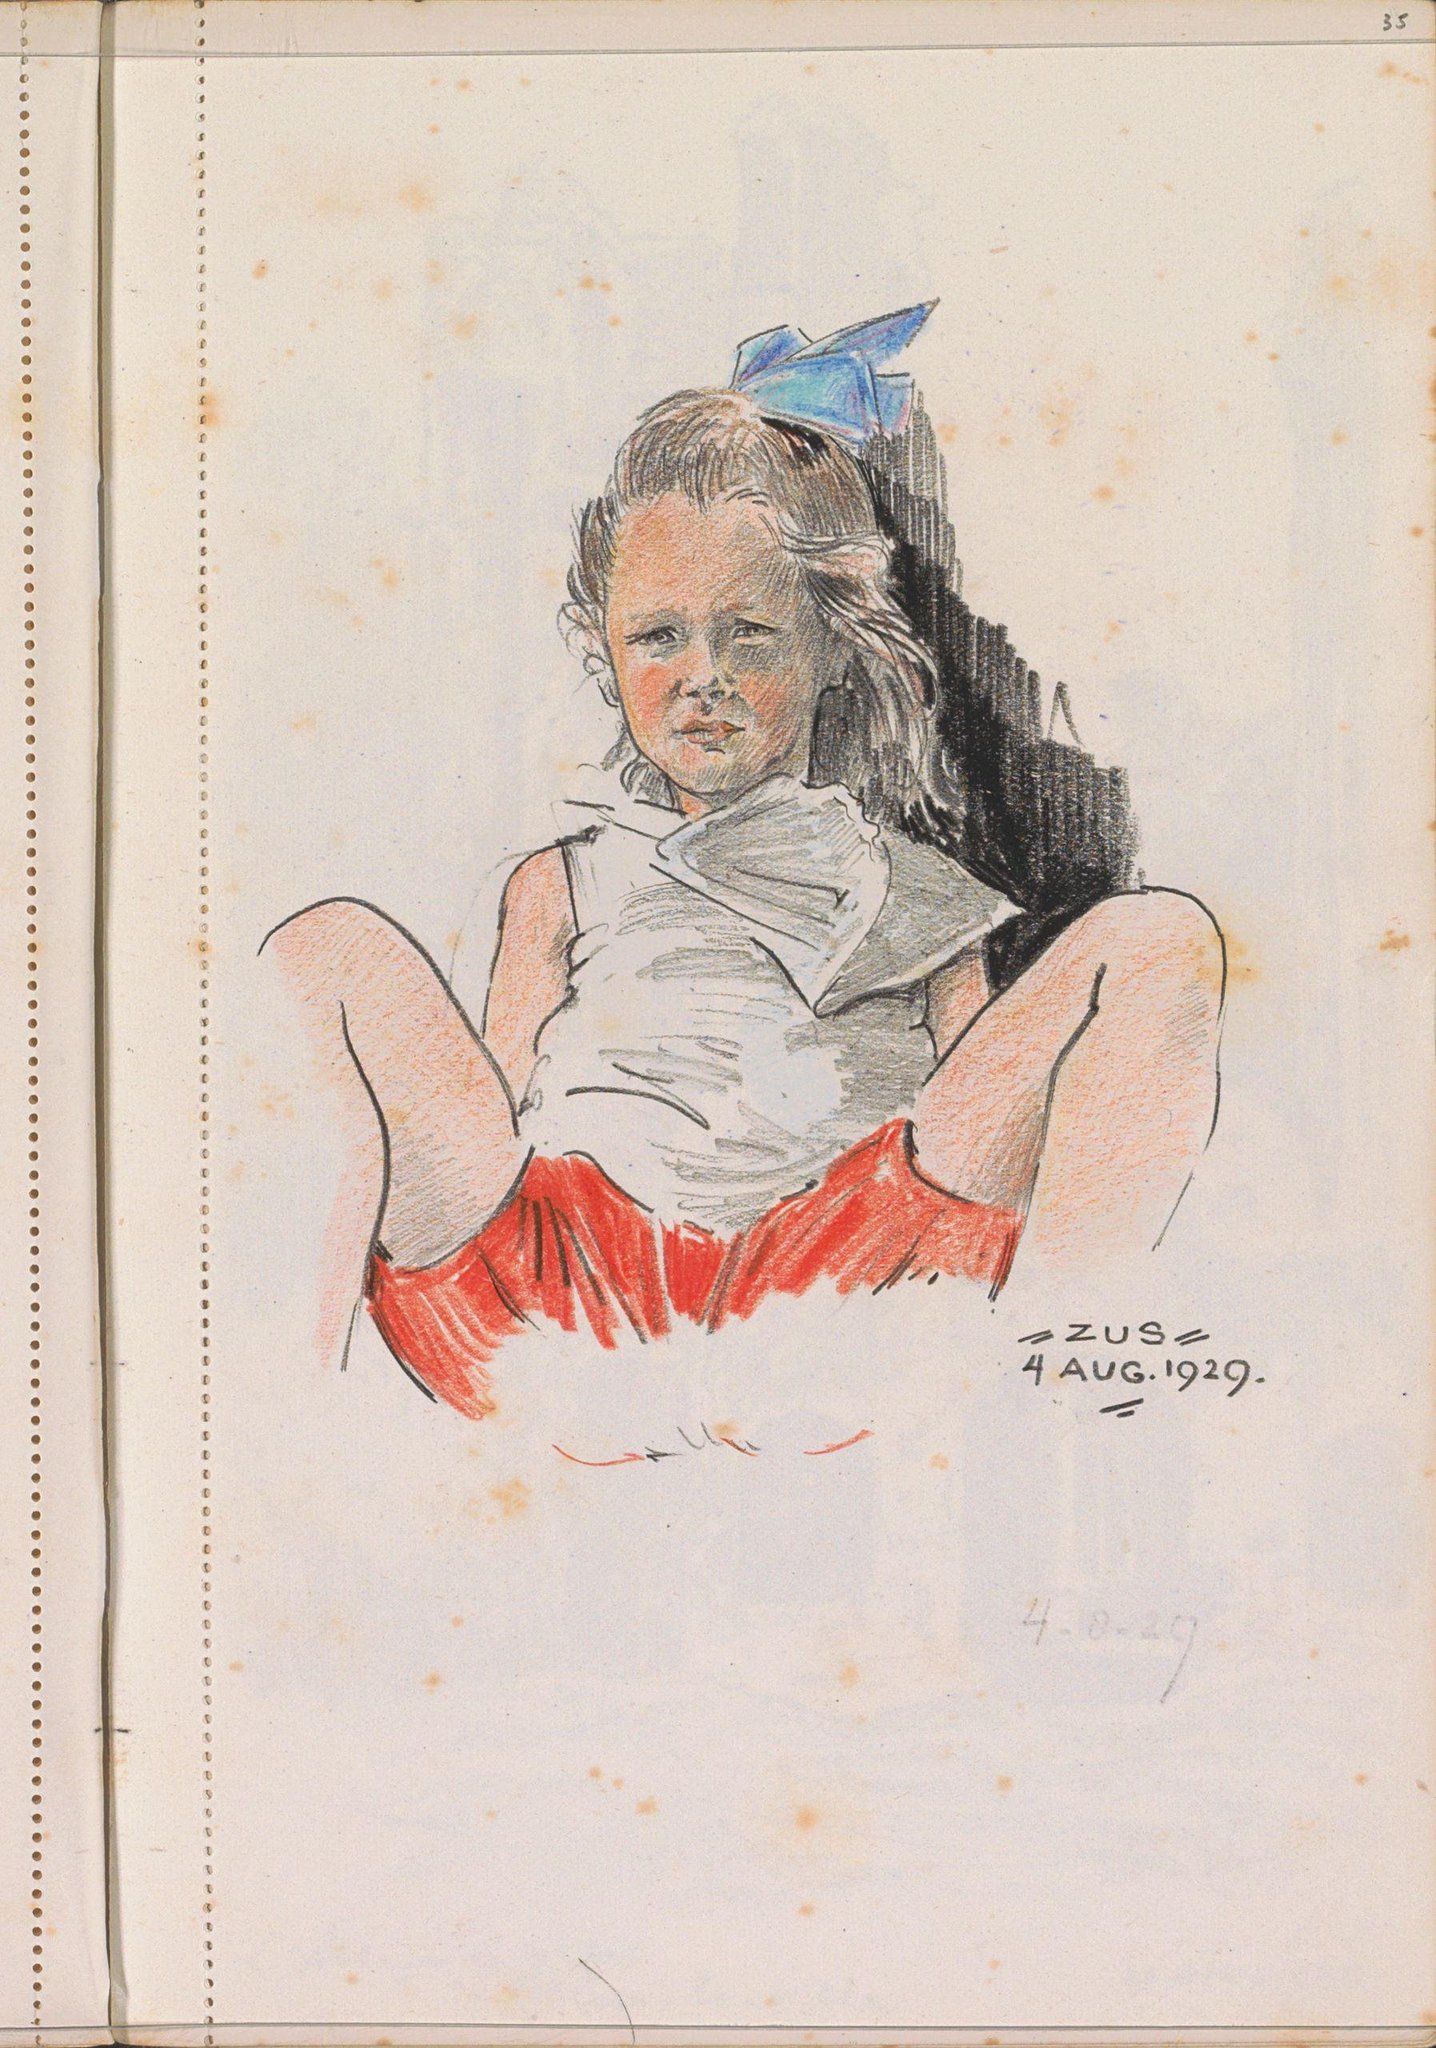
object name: sketchbook leaf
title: Portret van Zus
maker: otto verhagen (i)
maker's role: draughtsman, print maker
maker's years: 1885-1951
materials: chalk, paper, pencil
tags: sitting figure (+ young female (human being)), historical persons (portraits and scenes from the life)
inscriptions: date and inscription: ‘=ZUS=/ 4 AUG. 1929/ 4-8-29’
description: Het meisje zit met opgetrokken benen tegen een muur en draagt een strik in het haar. Pagina 35 uit een schetsboek met 51 bladen.